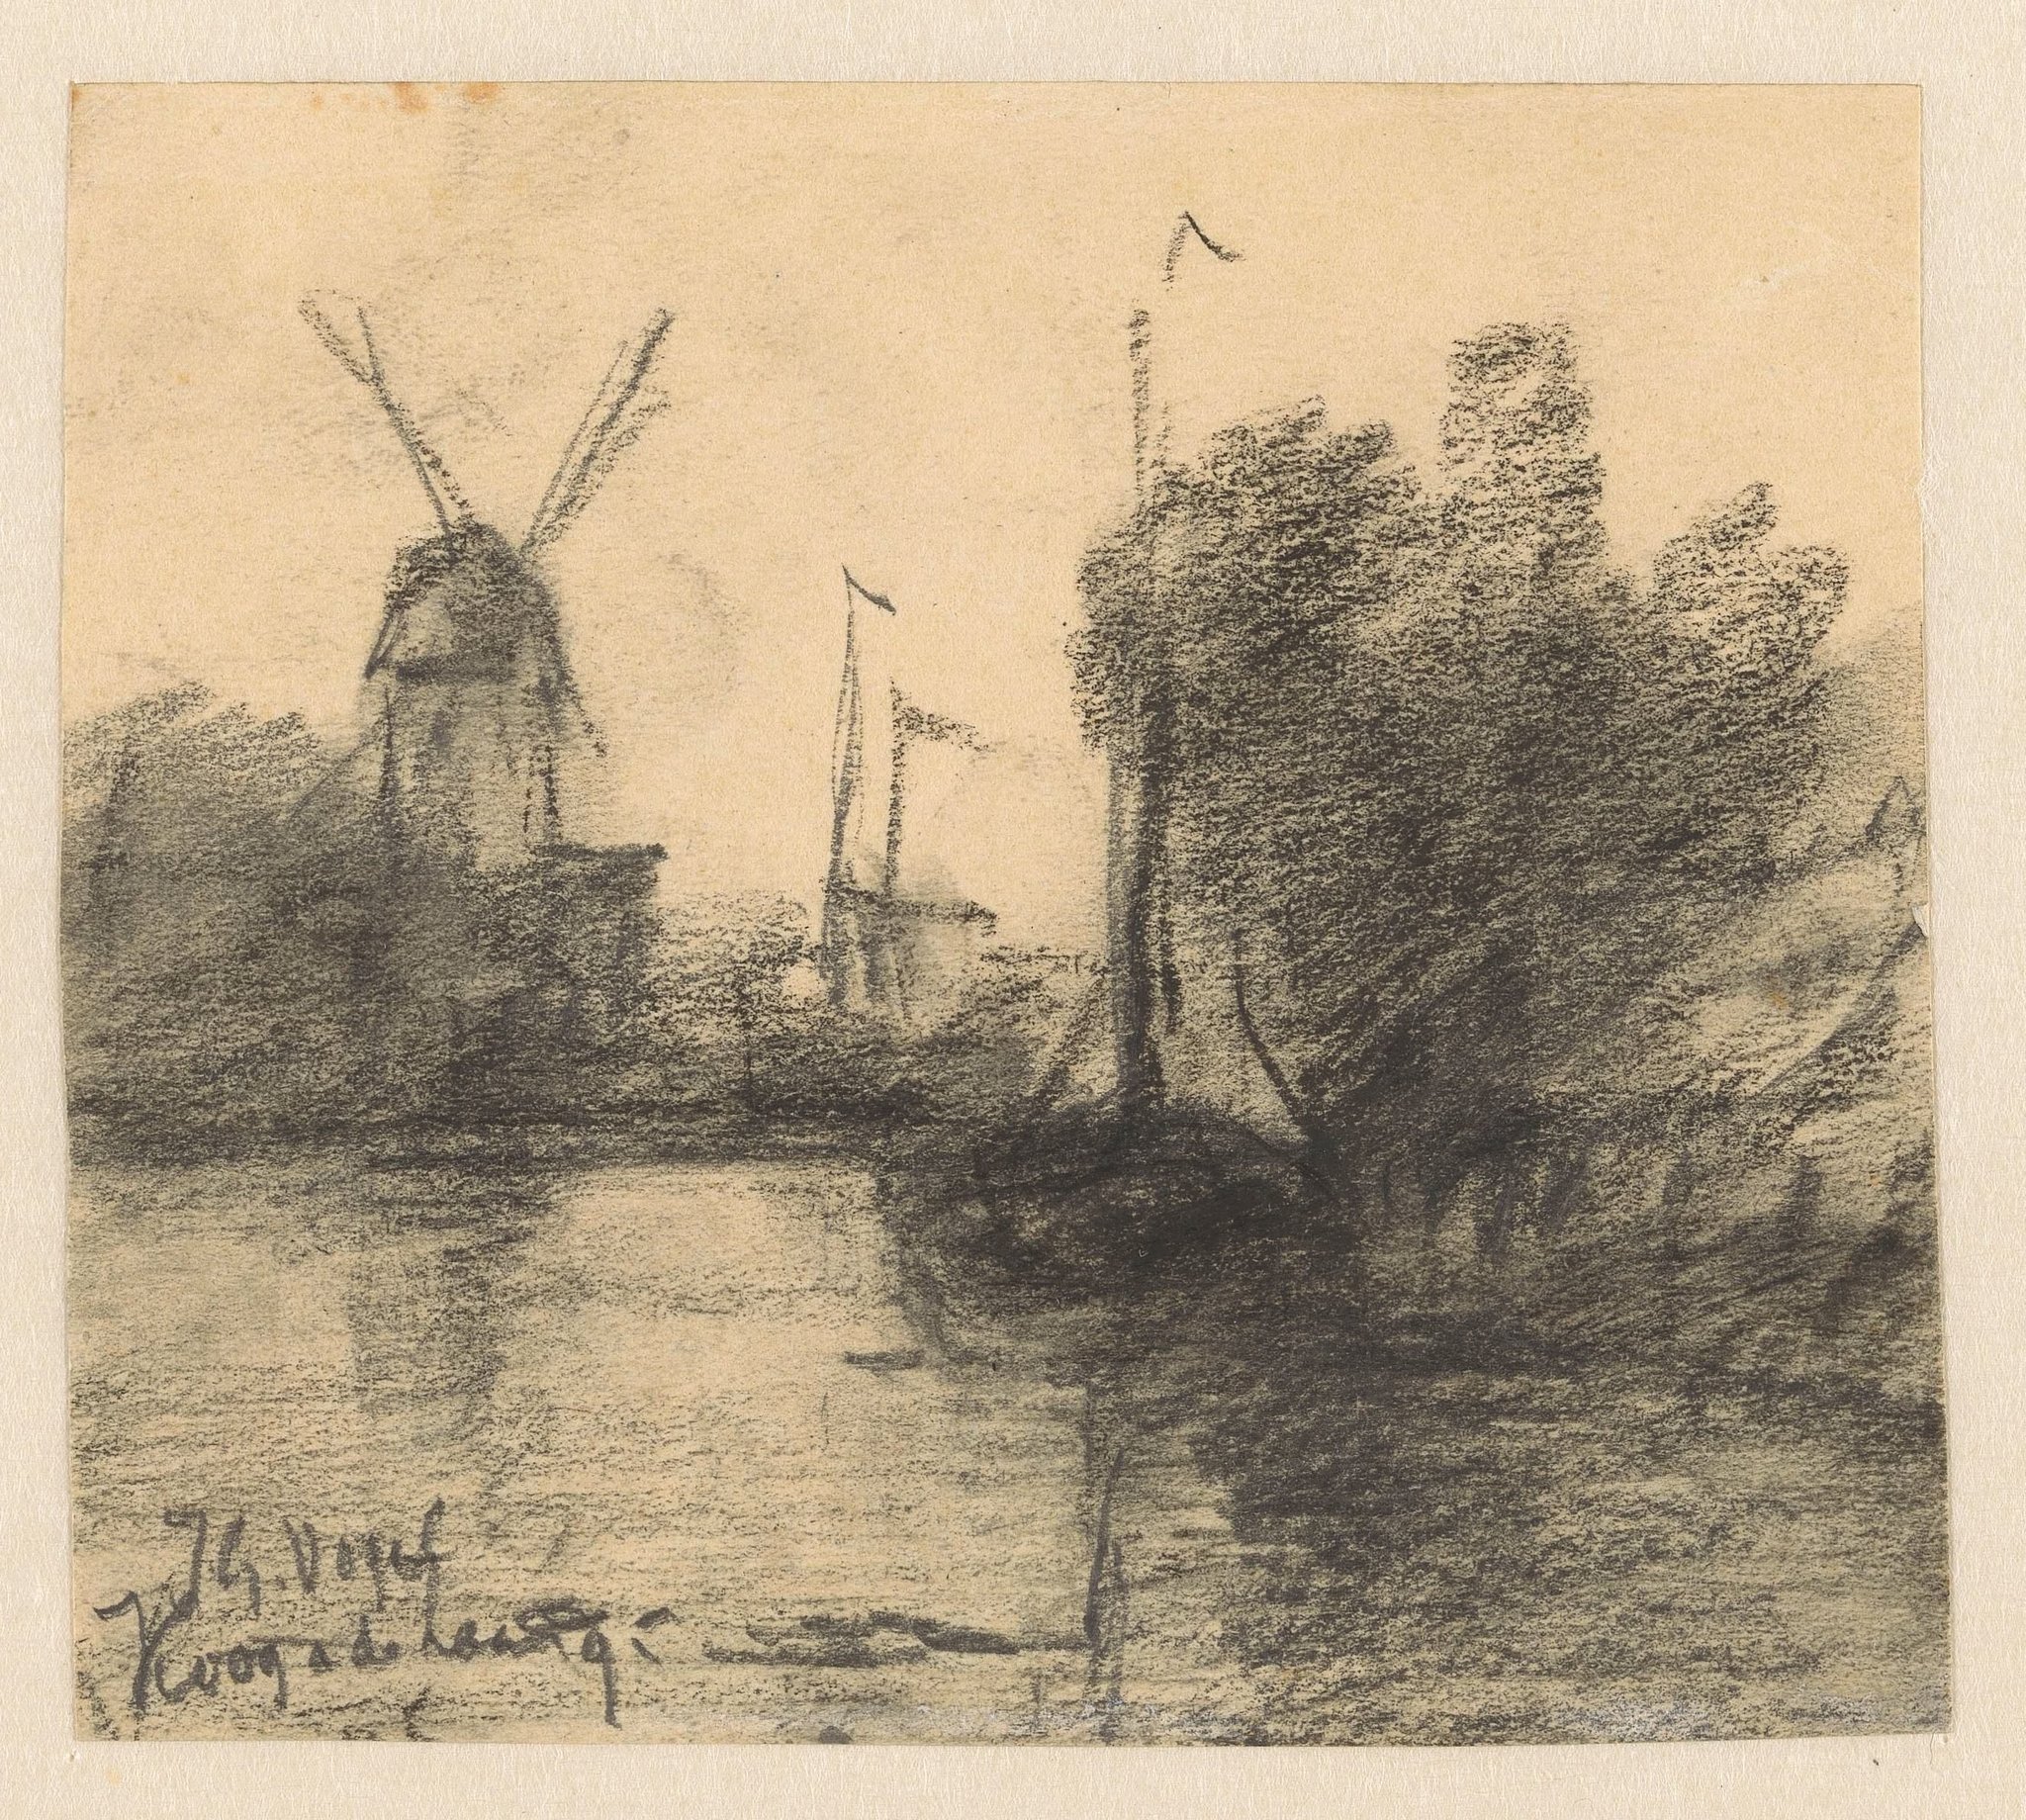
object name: drawing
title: Molens aan het water bij Koog aan de Zaan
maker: johannes gijsbert vogel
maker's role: draughtsman, painter, print maker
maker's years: 1828-1915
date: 1895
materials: chalk, paper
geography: koog aan de zaan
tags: river, prospect of city, town panorama, silhouette of city, koog aan de zaan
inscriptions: date